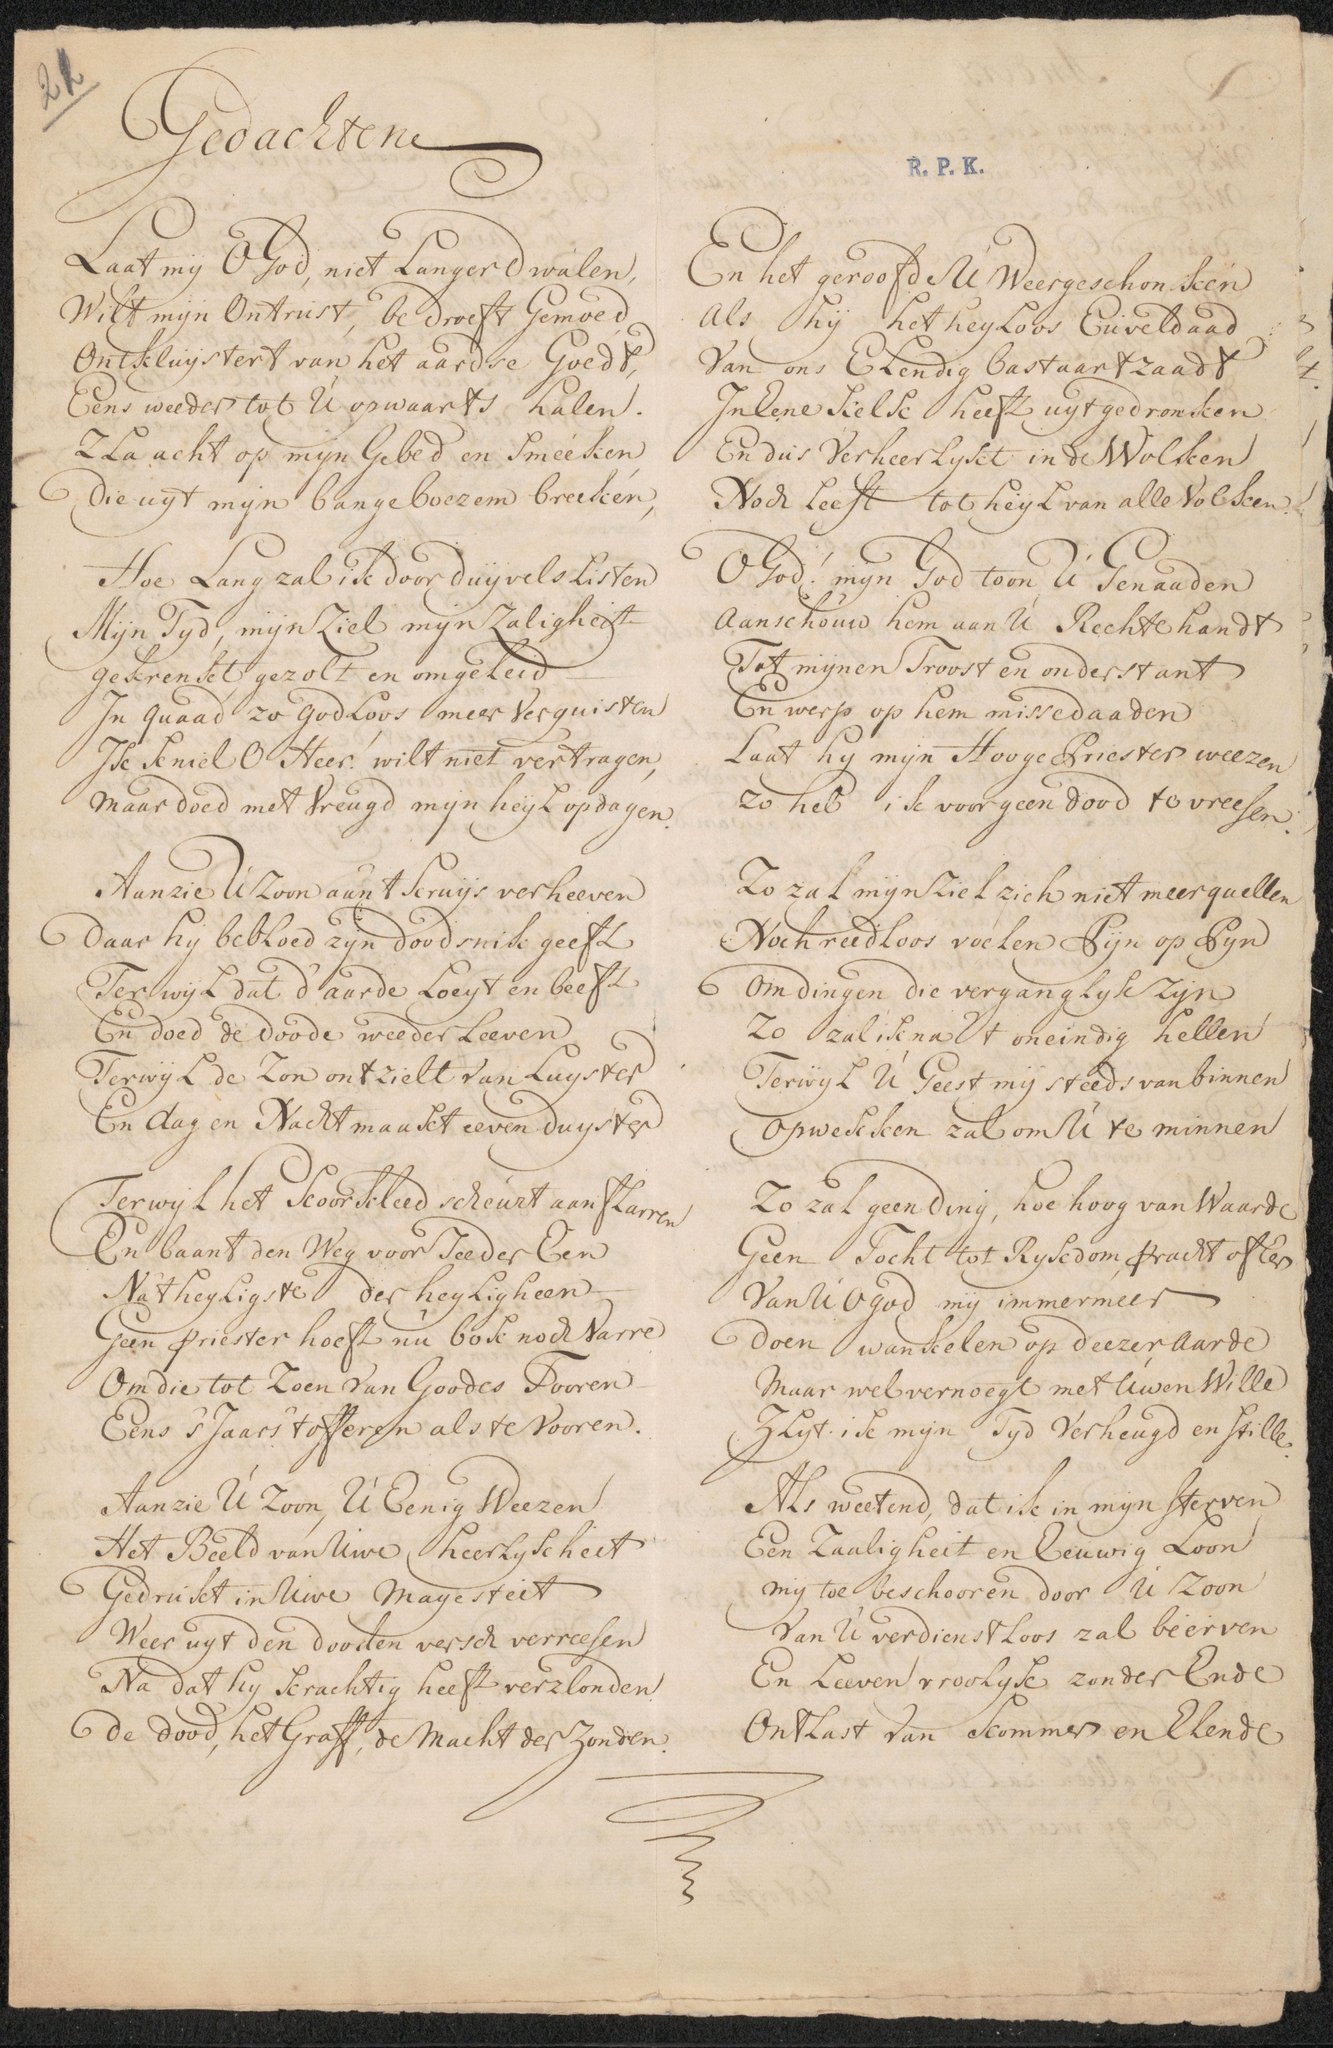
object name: poem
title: Gedicht aan anoniem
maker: Anonymous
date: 1641-1708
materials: ink, paper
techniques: pen, writing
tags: christian religion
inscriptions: watermark, collector's mark: Lugt 2233